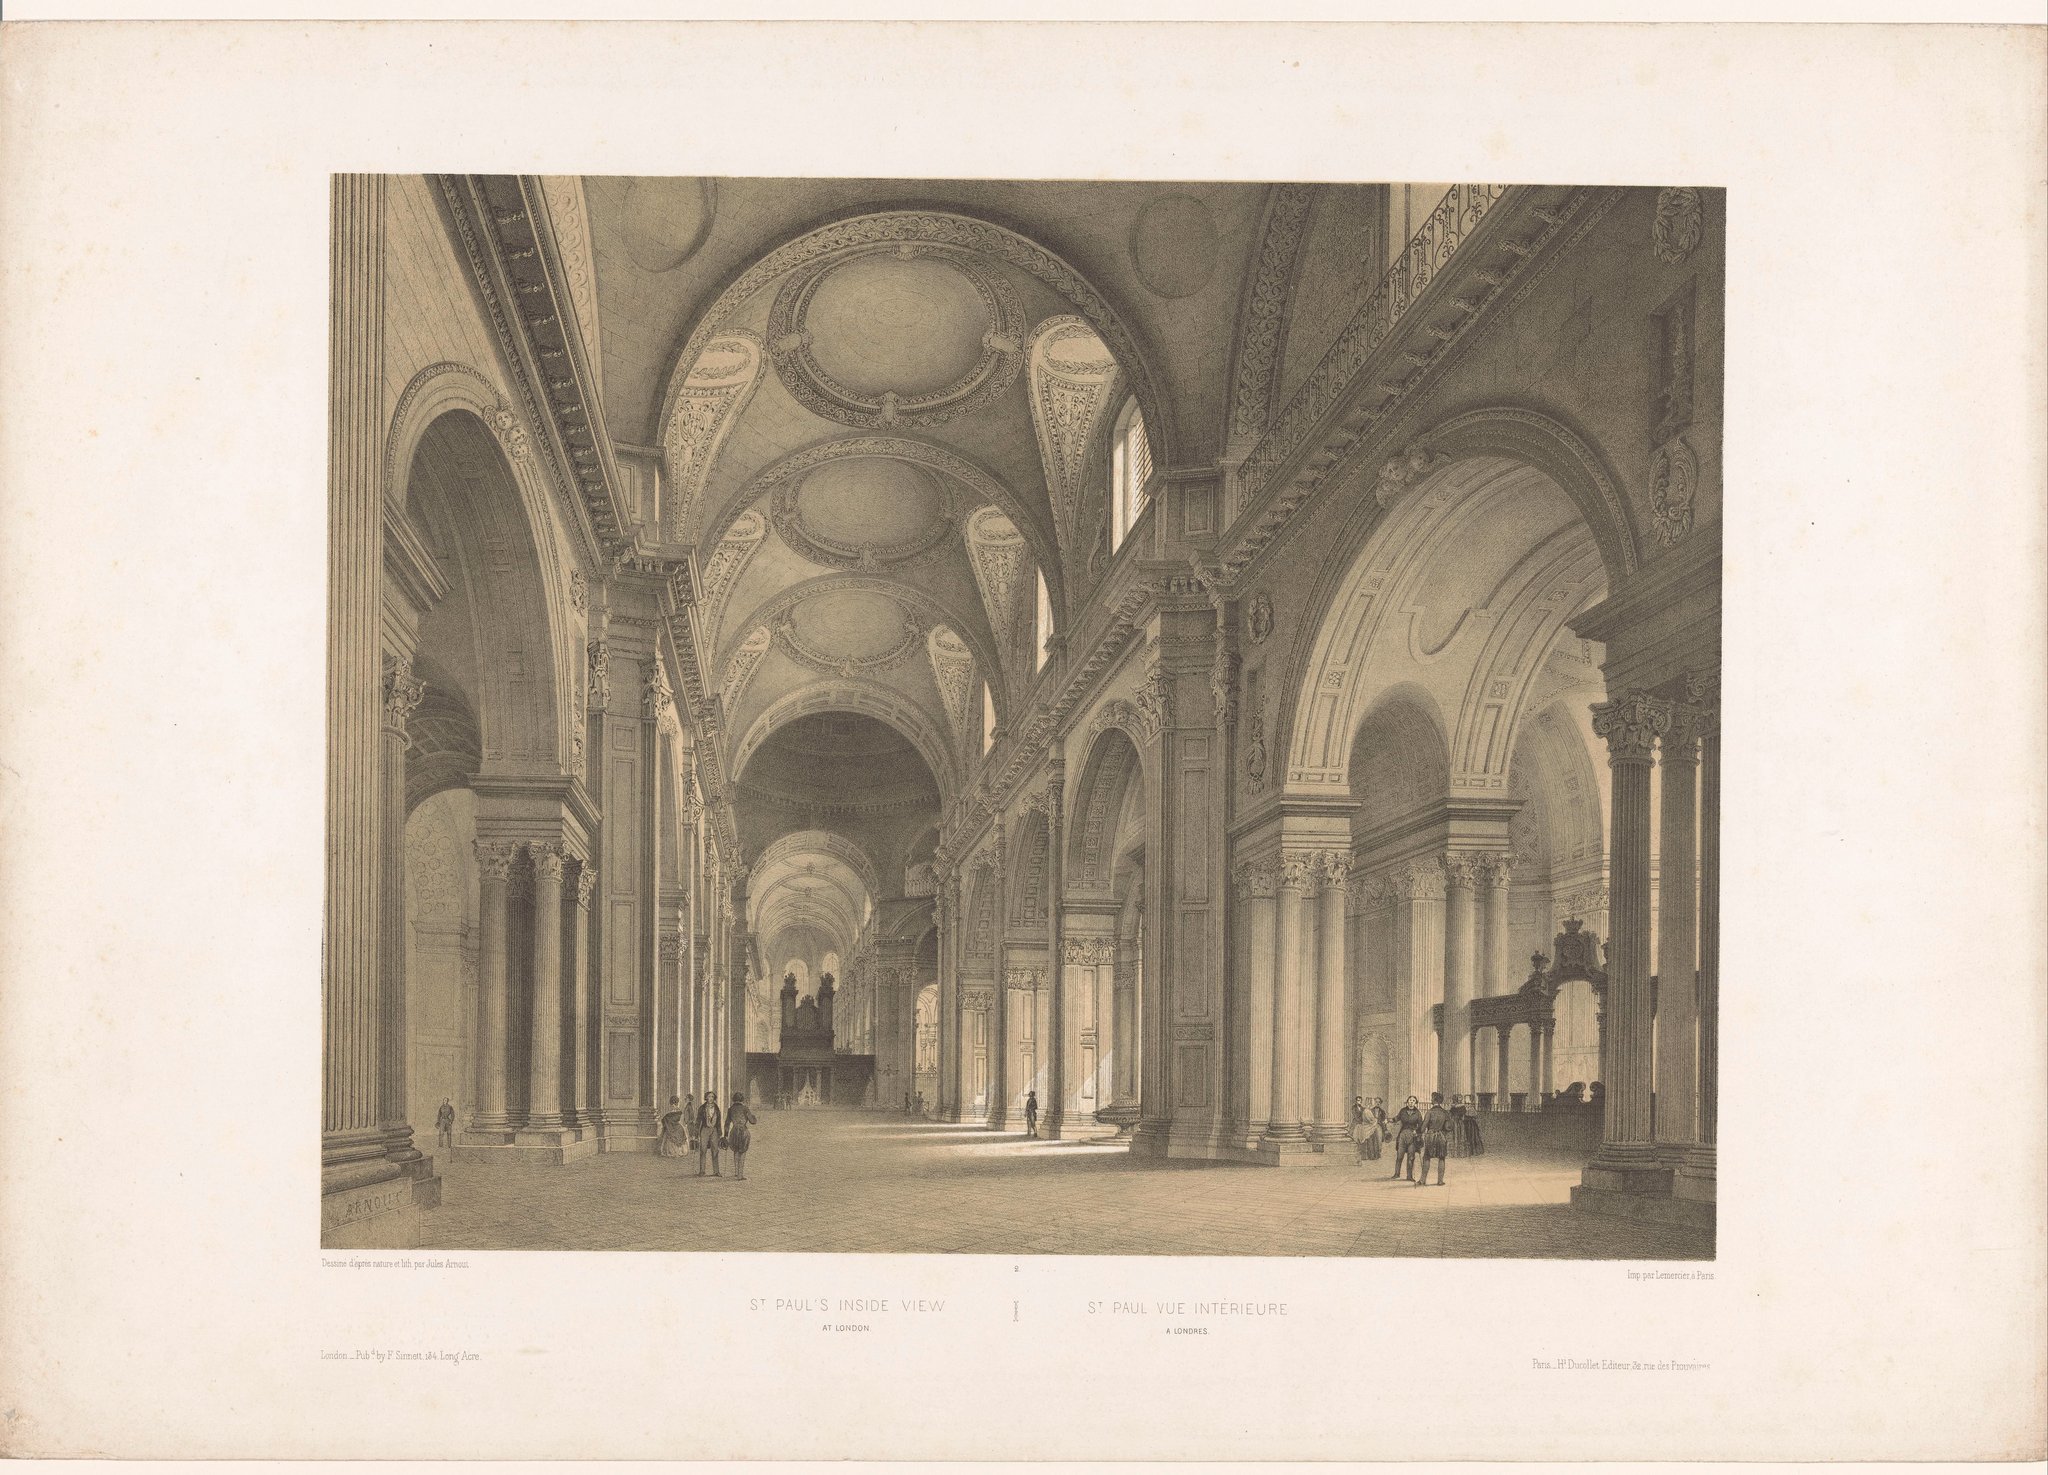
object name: print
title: England, Ireland & Scotland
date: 1847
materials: paper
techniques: tone lithography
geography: london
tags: interior of church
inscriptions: collector's mark: Lugt 2228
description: De serie werd aanvankelijk uitgegeven door Sinnett (Londen) en Ducollet (Parijs) in 1847. In 1855-1856 verscheen een heruitgave en vervolg van de serie bij Gambart (Londen) en Bulla (Parijs).